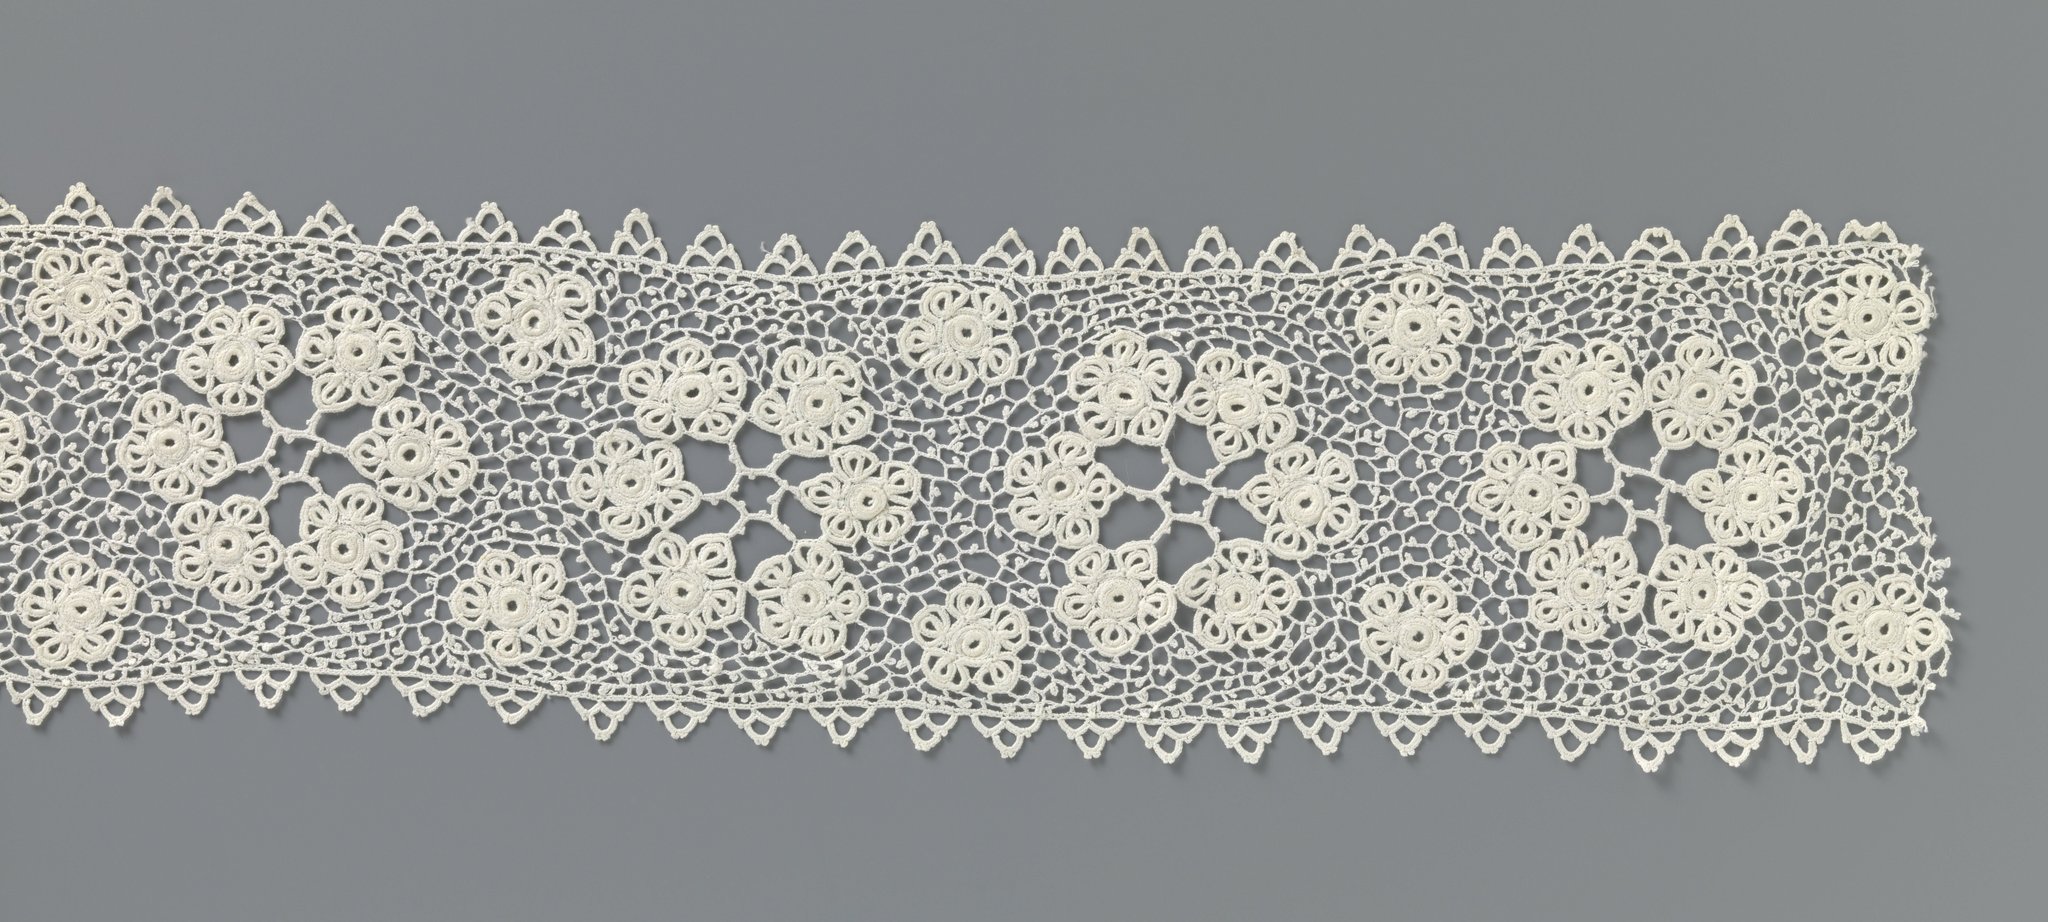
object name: strip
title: Strook gehaakte kant met rozettenkrans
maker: Anonymous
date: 1890-1909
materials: cotton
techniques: crocheted lace, irish crochet lace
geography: ireland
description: Het is een aanname dat deze Ierse gehaakte kant ook daadwerkelijk in Ierland is gemaakt. Ierse gehaakte kant kent zijn oorsprong rond 1760 en kwam vanaf 1840 in ontwikkeling. Aangezien volgens Martine Bruggeman (Kant in Europa) de Ierse haakindustrie aan het eind van de 19e eeuw gereorganiseerd werd en in populariteit groeide, is het hier beschreven stuk gedateerd rond 1890, tot 1909 vanwege de datering in het eerste decennium van populariteit van Ierse gehaakte kant volgens het Kantlexicon (Johan Coene).